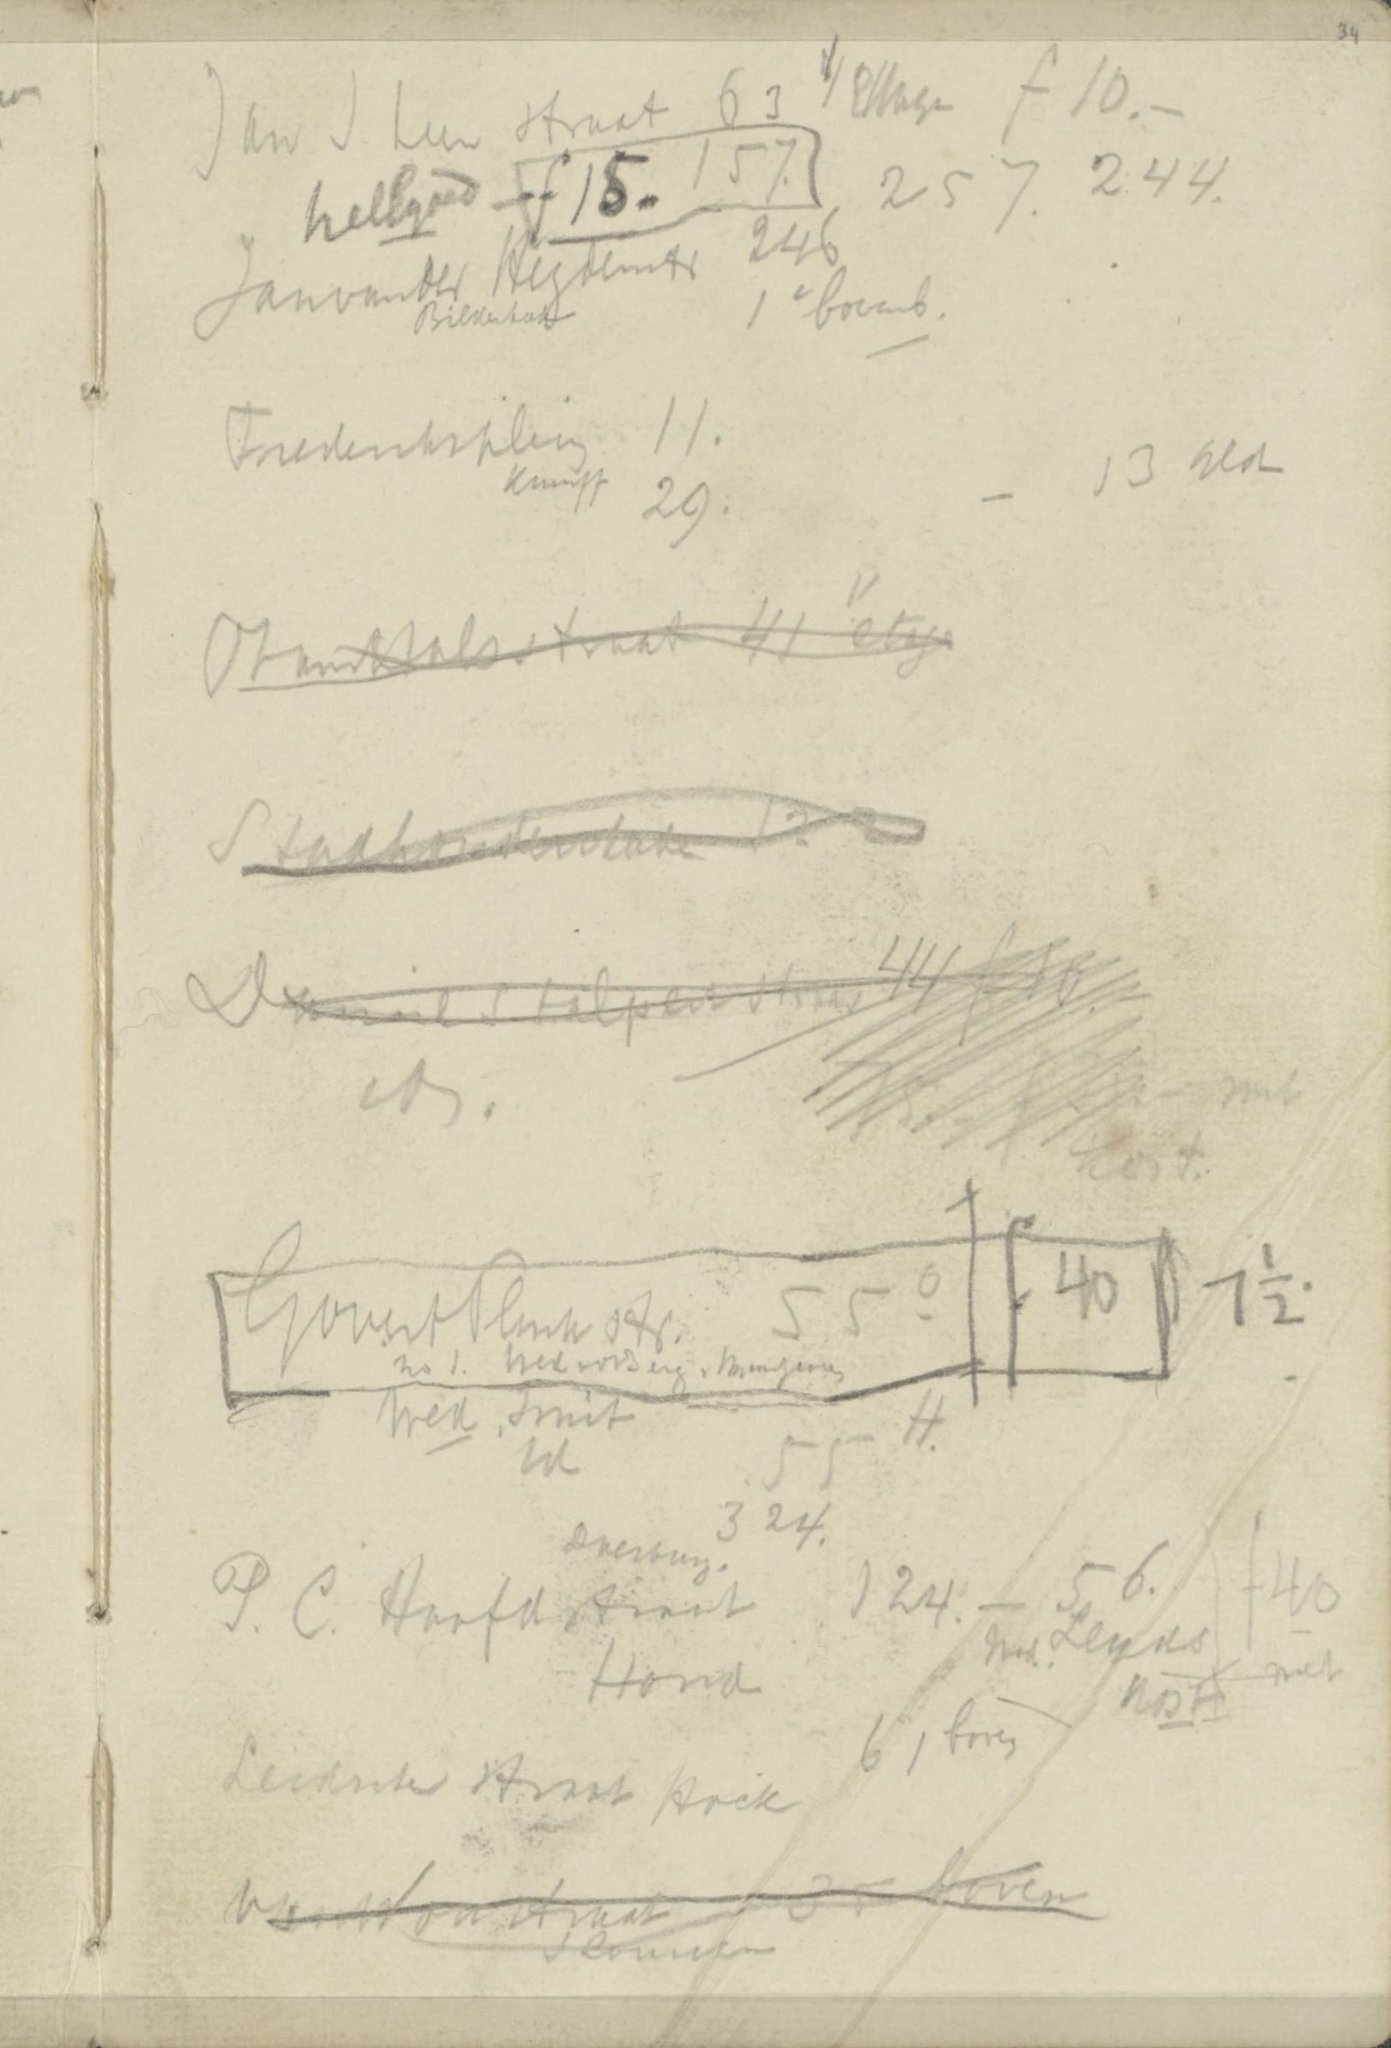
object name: sketchbook leaf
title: Annotaties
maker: george hendrik breitner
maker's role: draughtsman, painter, print maker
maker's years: 1857-1923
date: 1884-1886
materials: paper, pencil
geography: the hague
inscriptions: annotation: ‘Jan Steen straat 63 [...]’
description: Pagina 34 uit een schetsboek met 19 bladen.